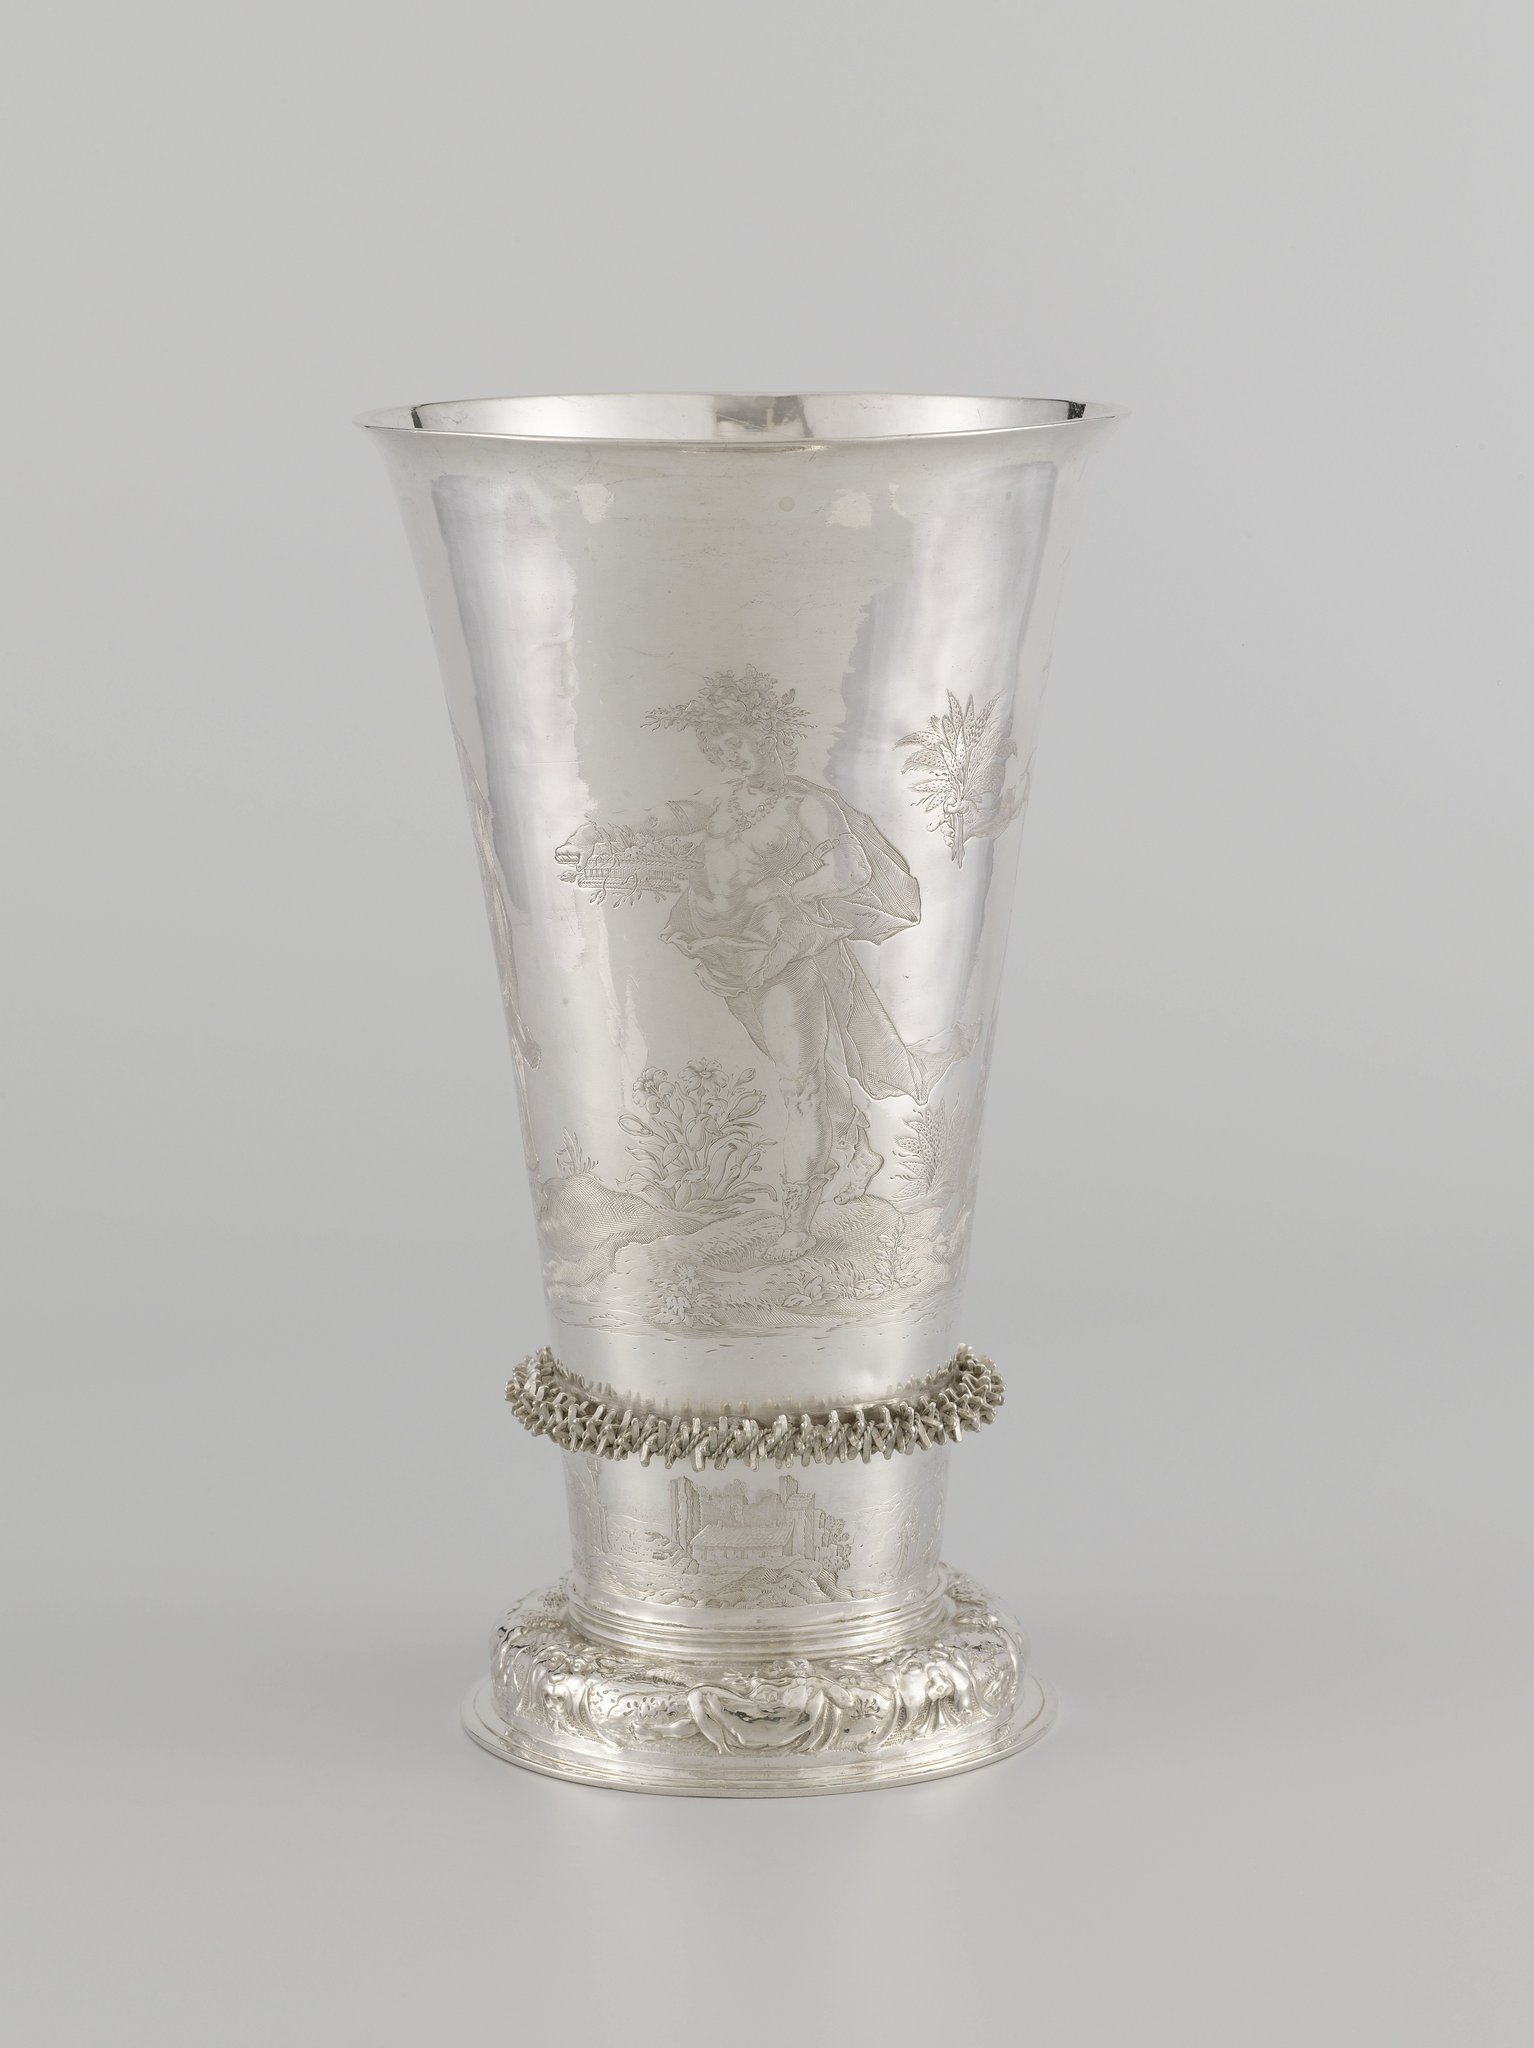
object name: cup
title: Beker met de vier jaargetijden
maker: Anonymous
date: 1600-1650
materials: silver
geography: groningen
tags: (story of) ceres (demeter), summer, 'aestas'; 'estate' (ripa)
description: Beaker with the four seasons after engravings by Jacob Matham. Silver. Groningen, c. 1600 - 1650.